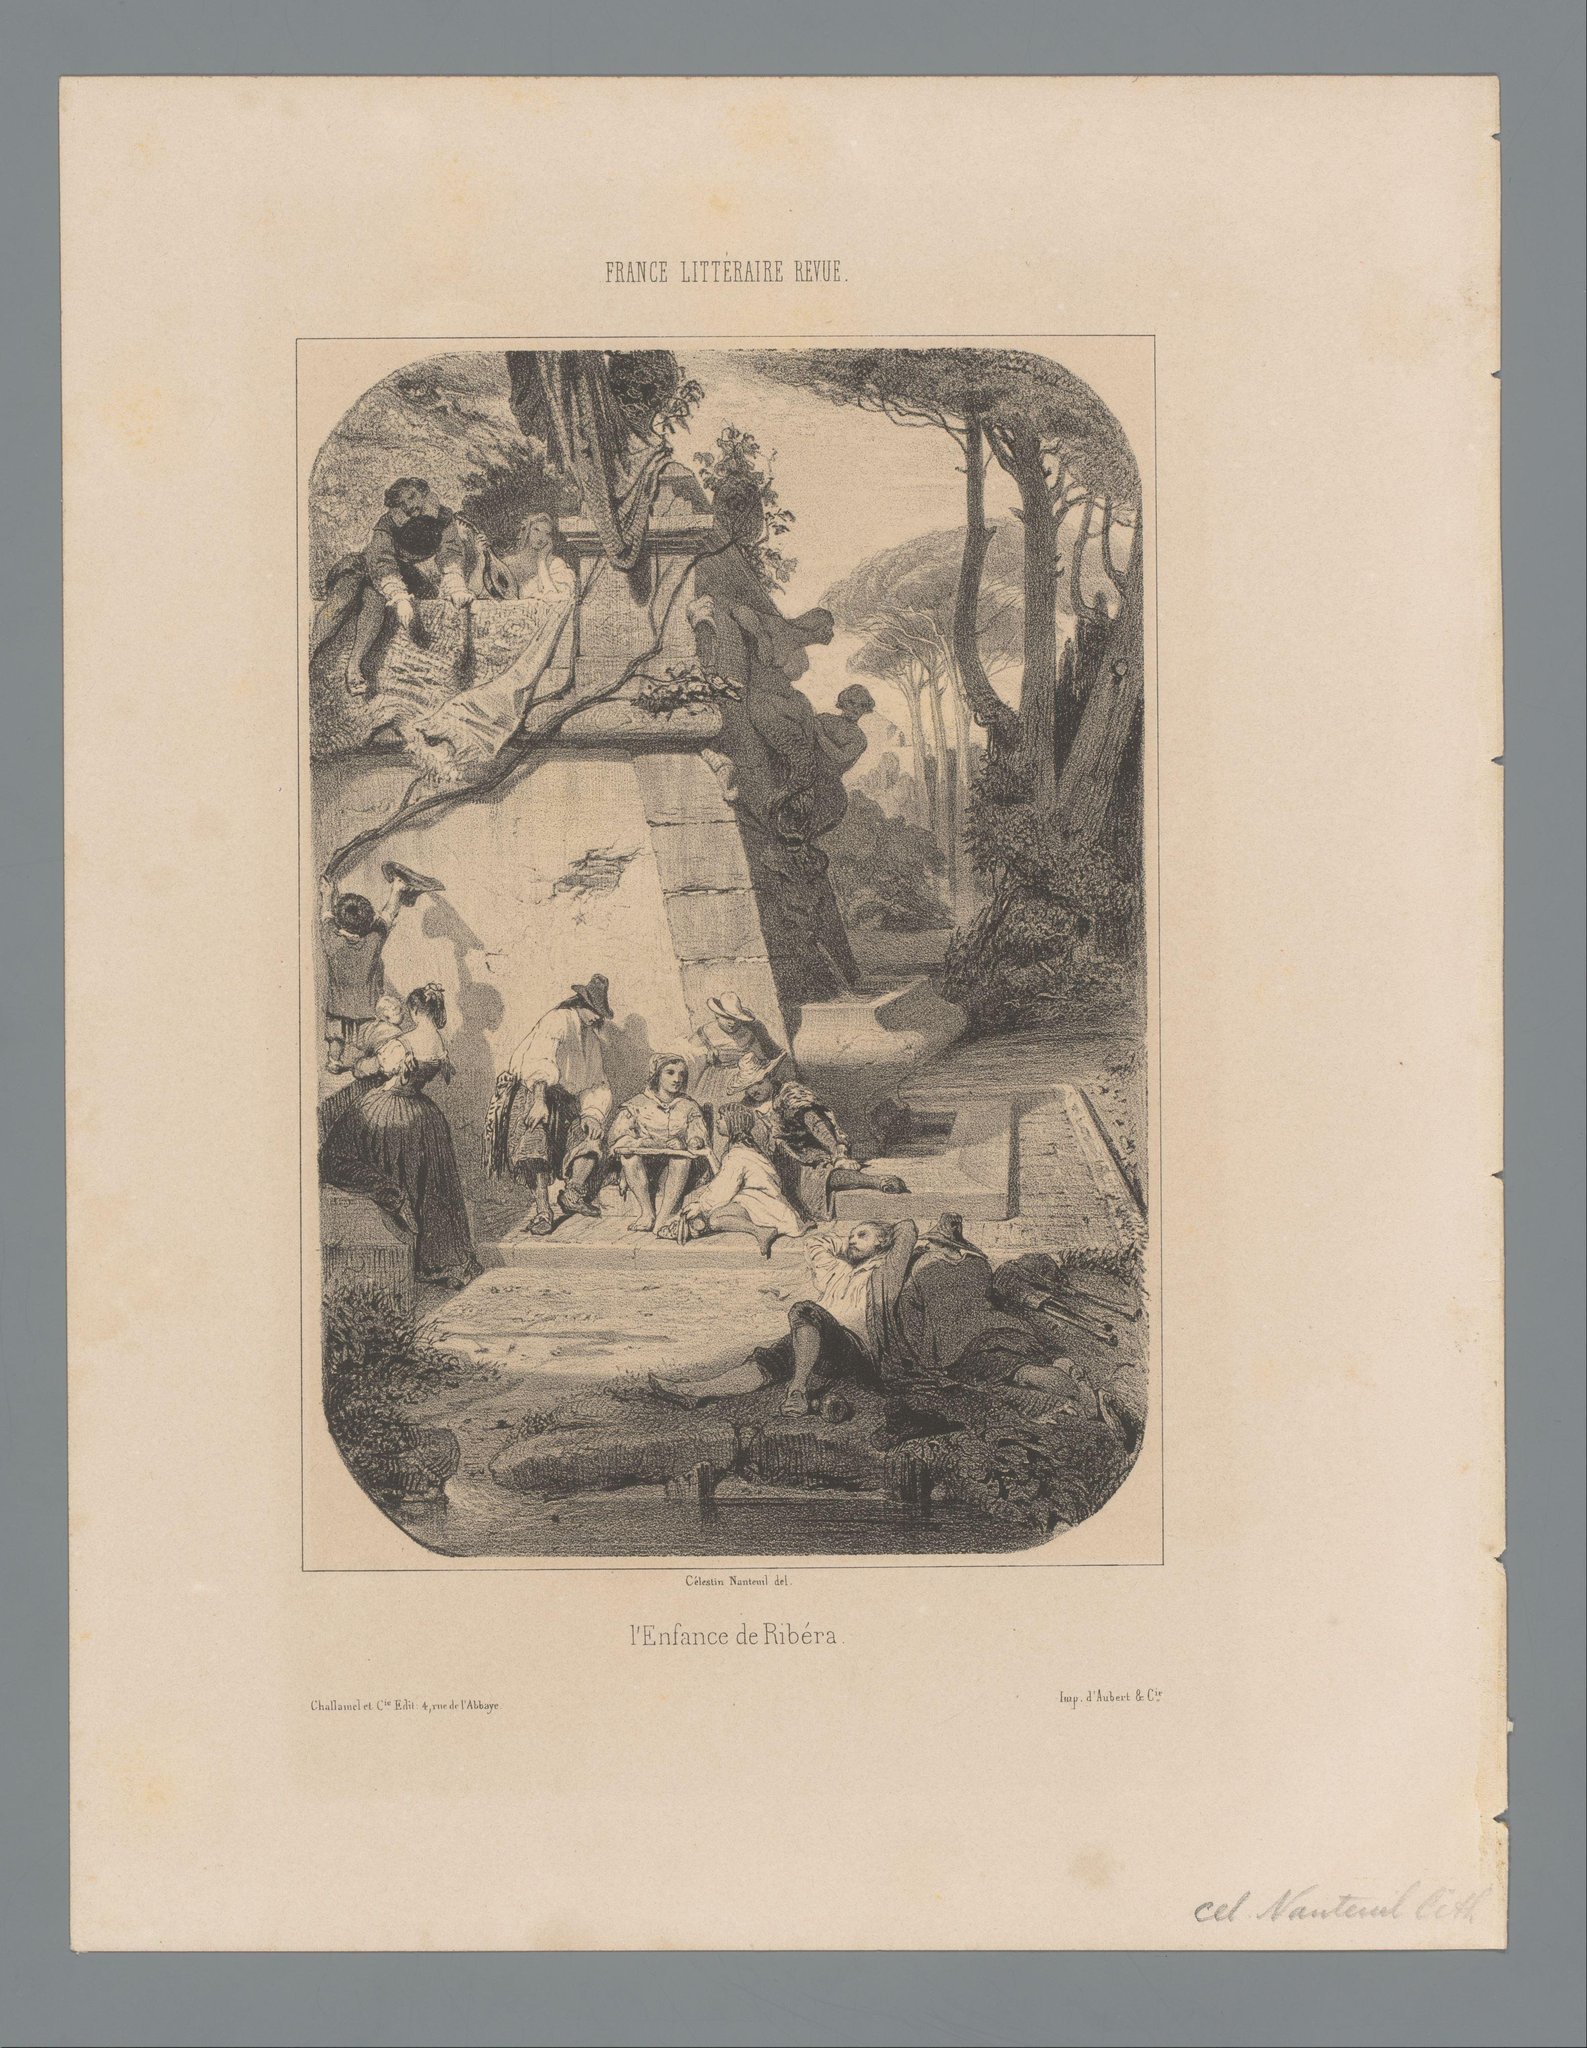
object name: print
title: Mensen op en rondom stenen bouwwerk tussen de bomen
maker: célestin françois nanteuil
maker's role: print maker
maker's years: 1813-1873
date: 1842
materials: paper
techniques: lithograph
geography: paris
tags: recreation, popular music, street music, lute, and special forms of lute, e.g.: theorbo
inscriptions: collector's mark: Lugt 2228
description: Prent gebruikt in: La France littéraire, 1842.